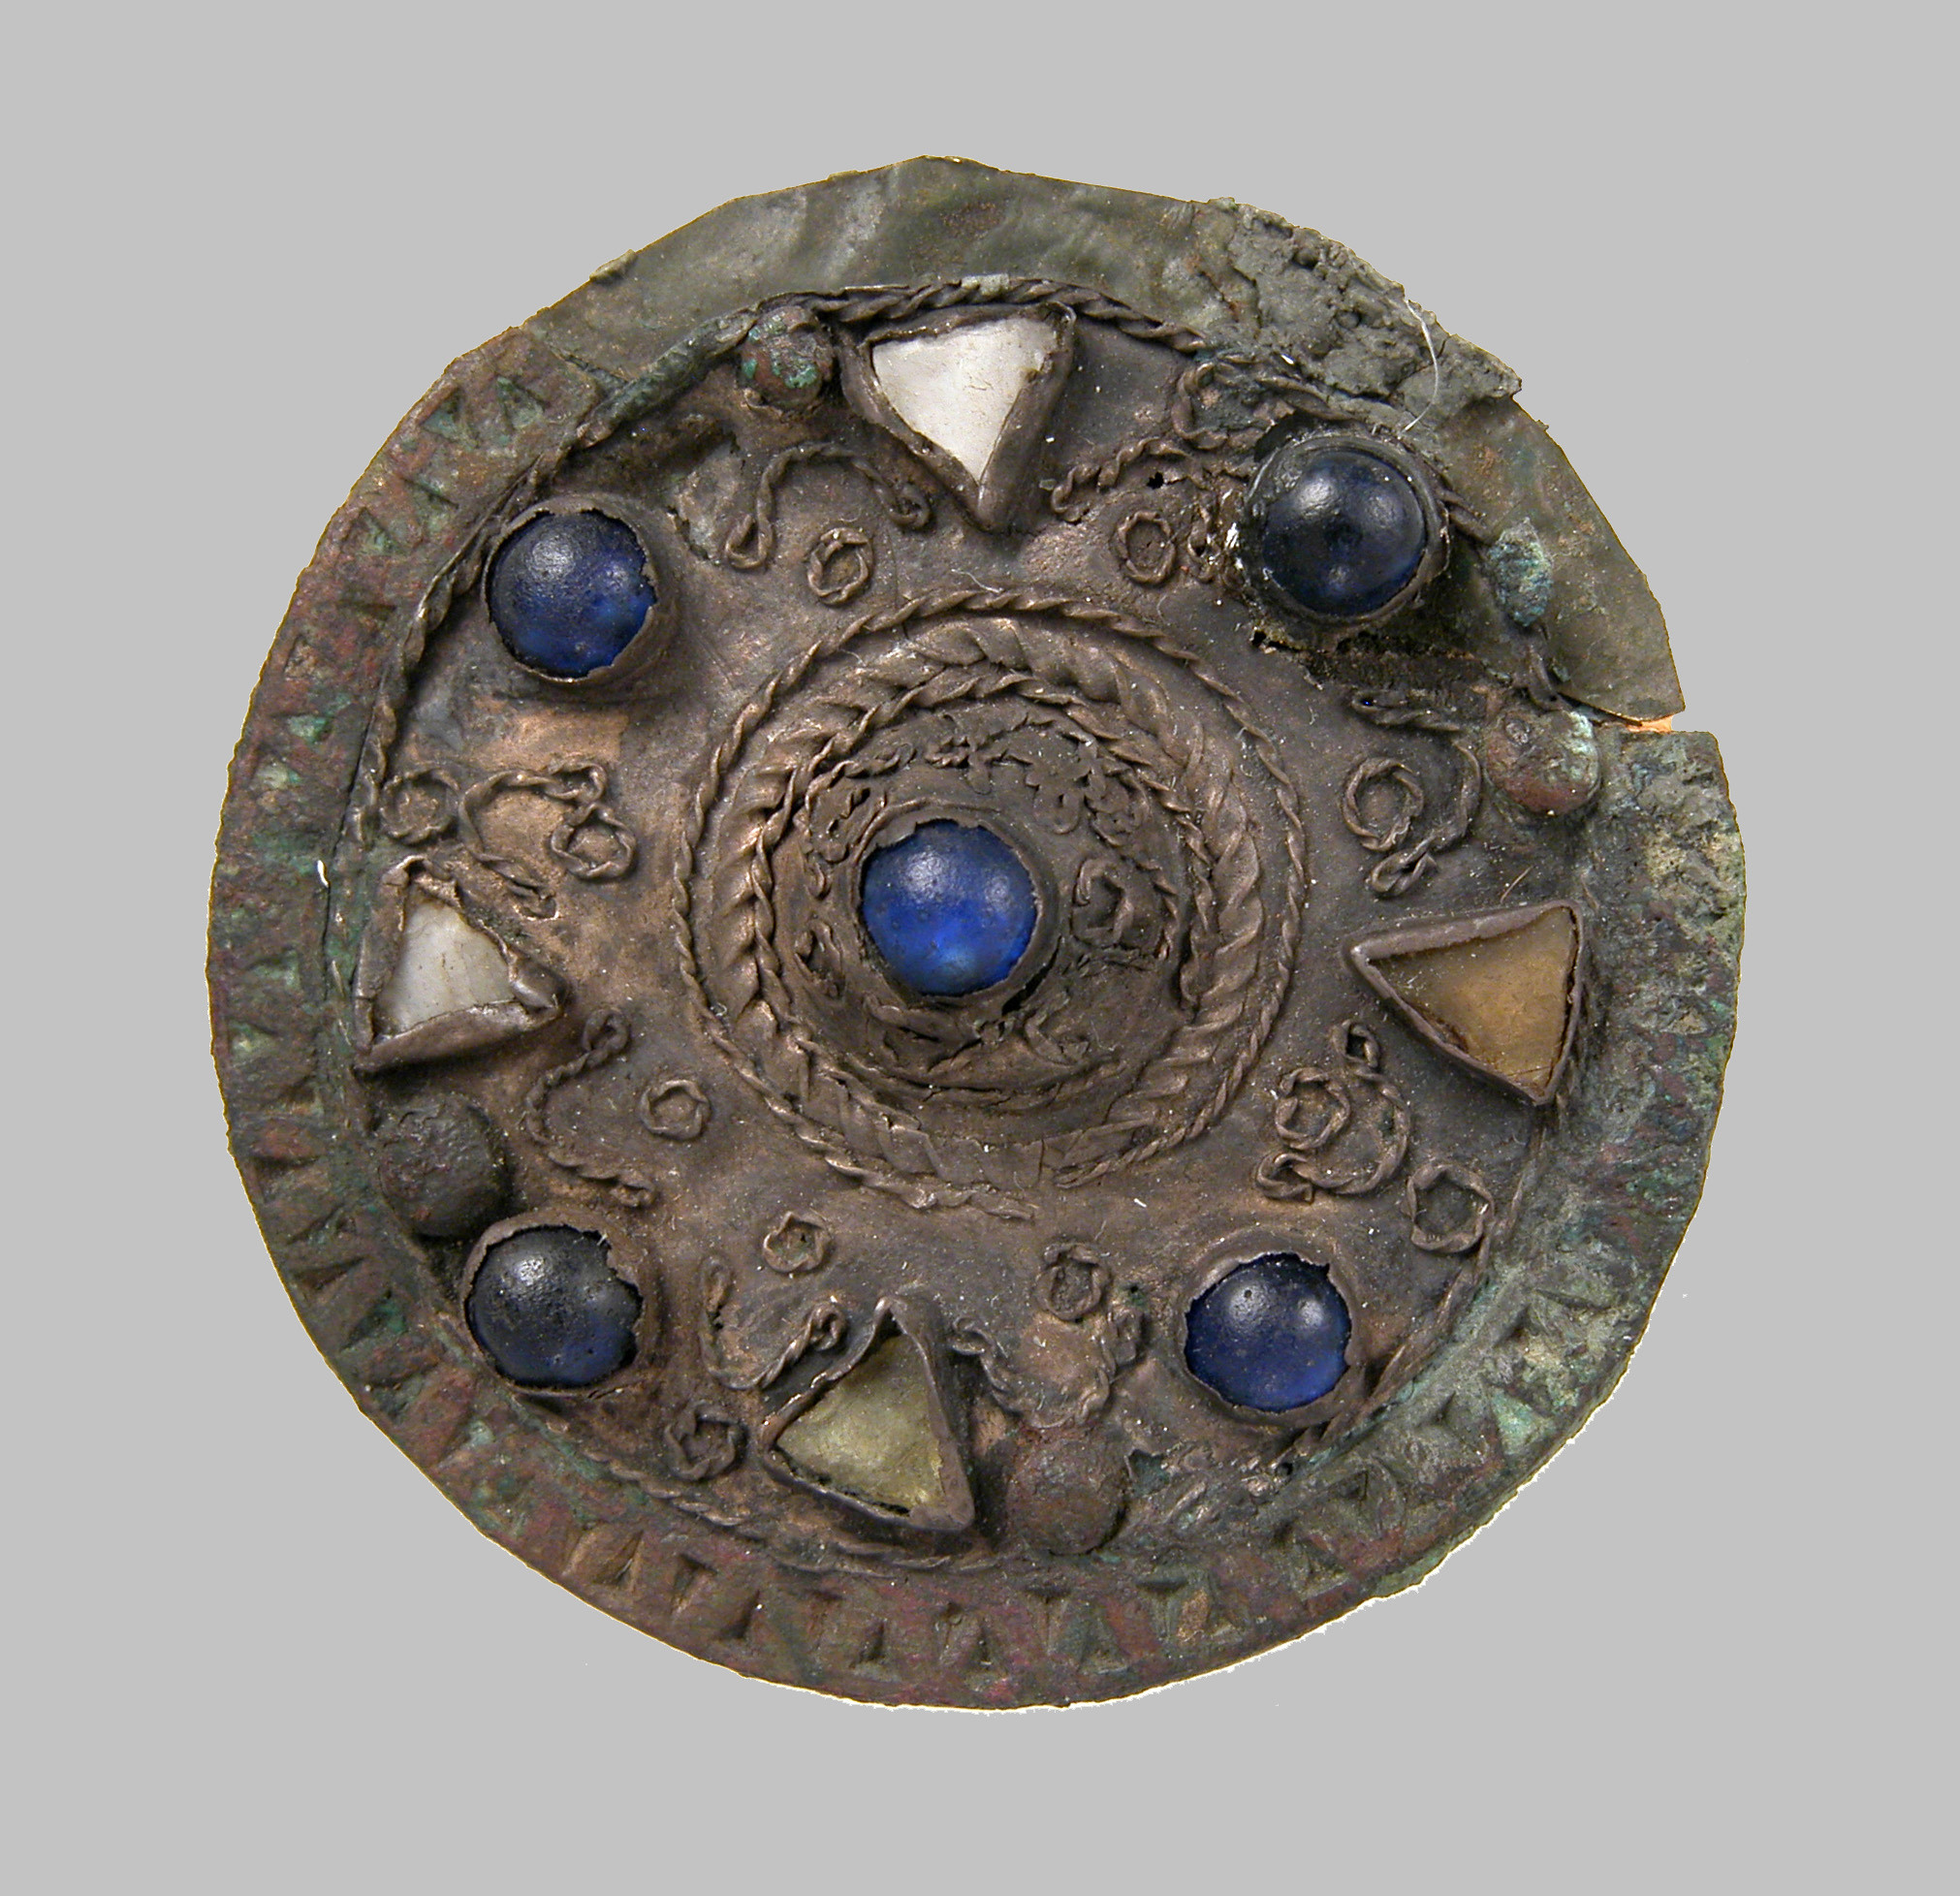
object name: brooch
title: Disk Brooch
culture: frankish or northern french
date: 600-650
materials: copper alloy, glass, paste, silver, metal